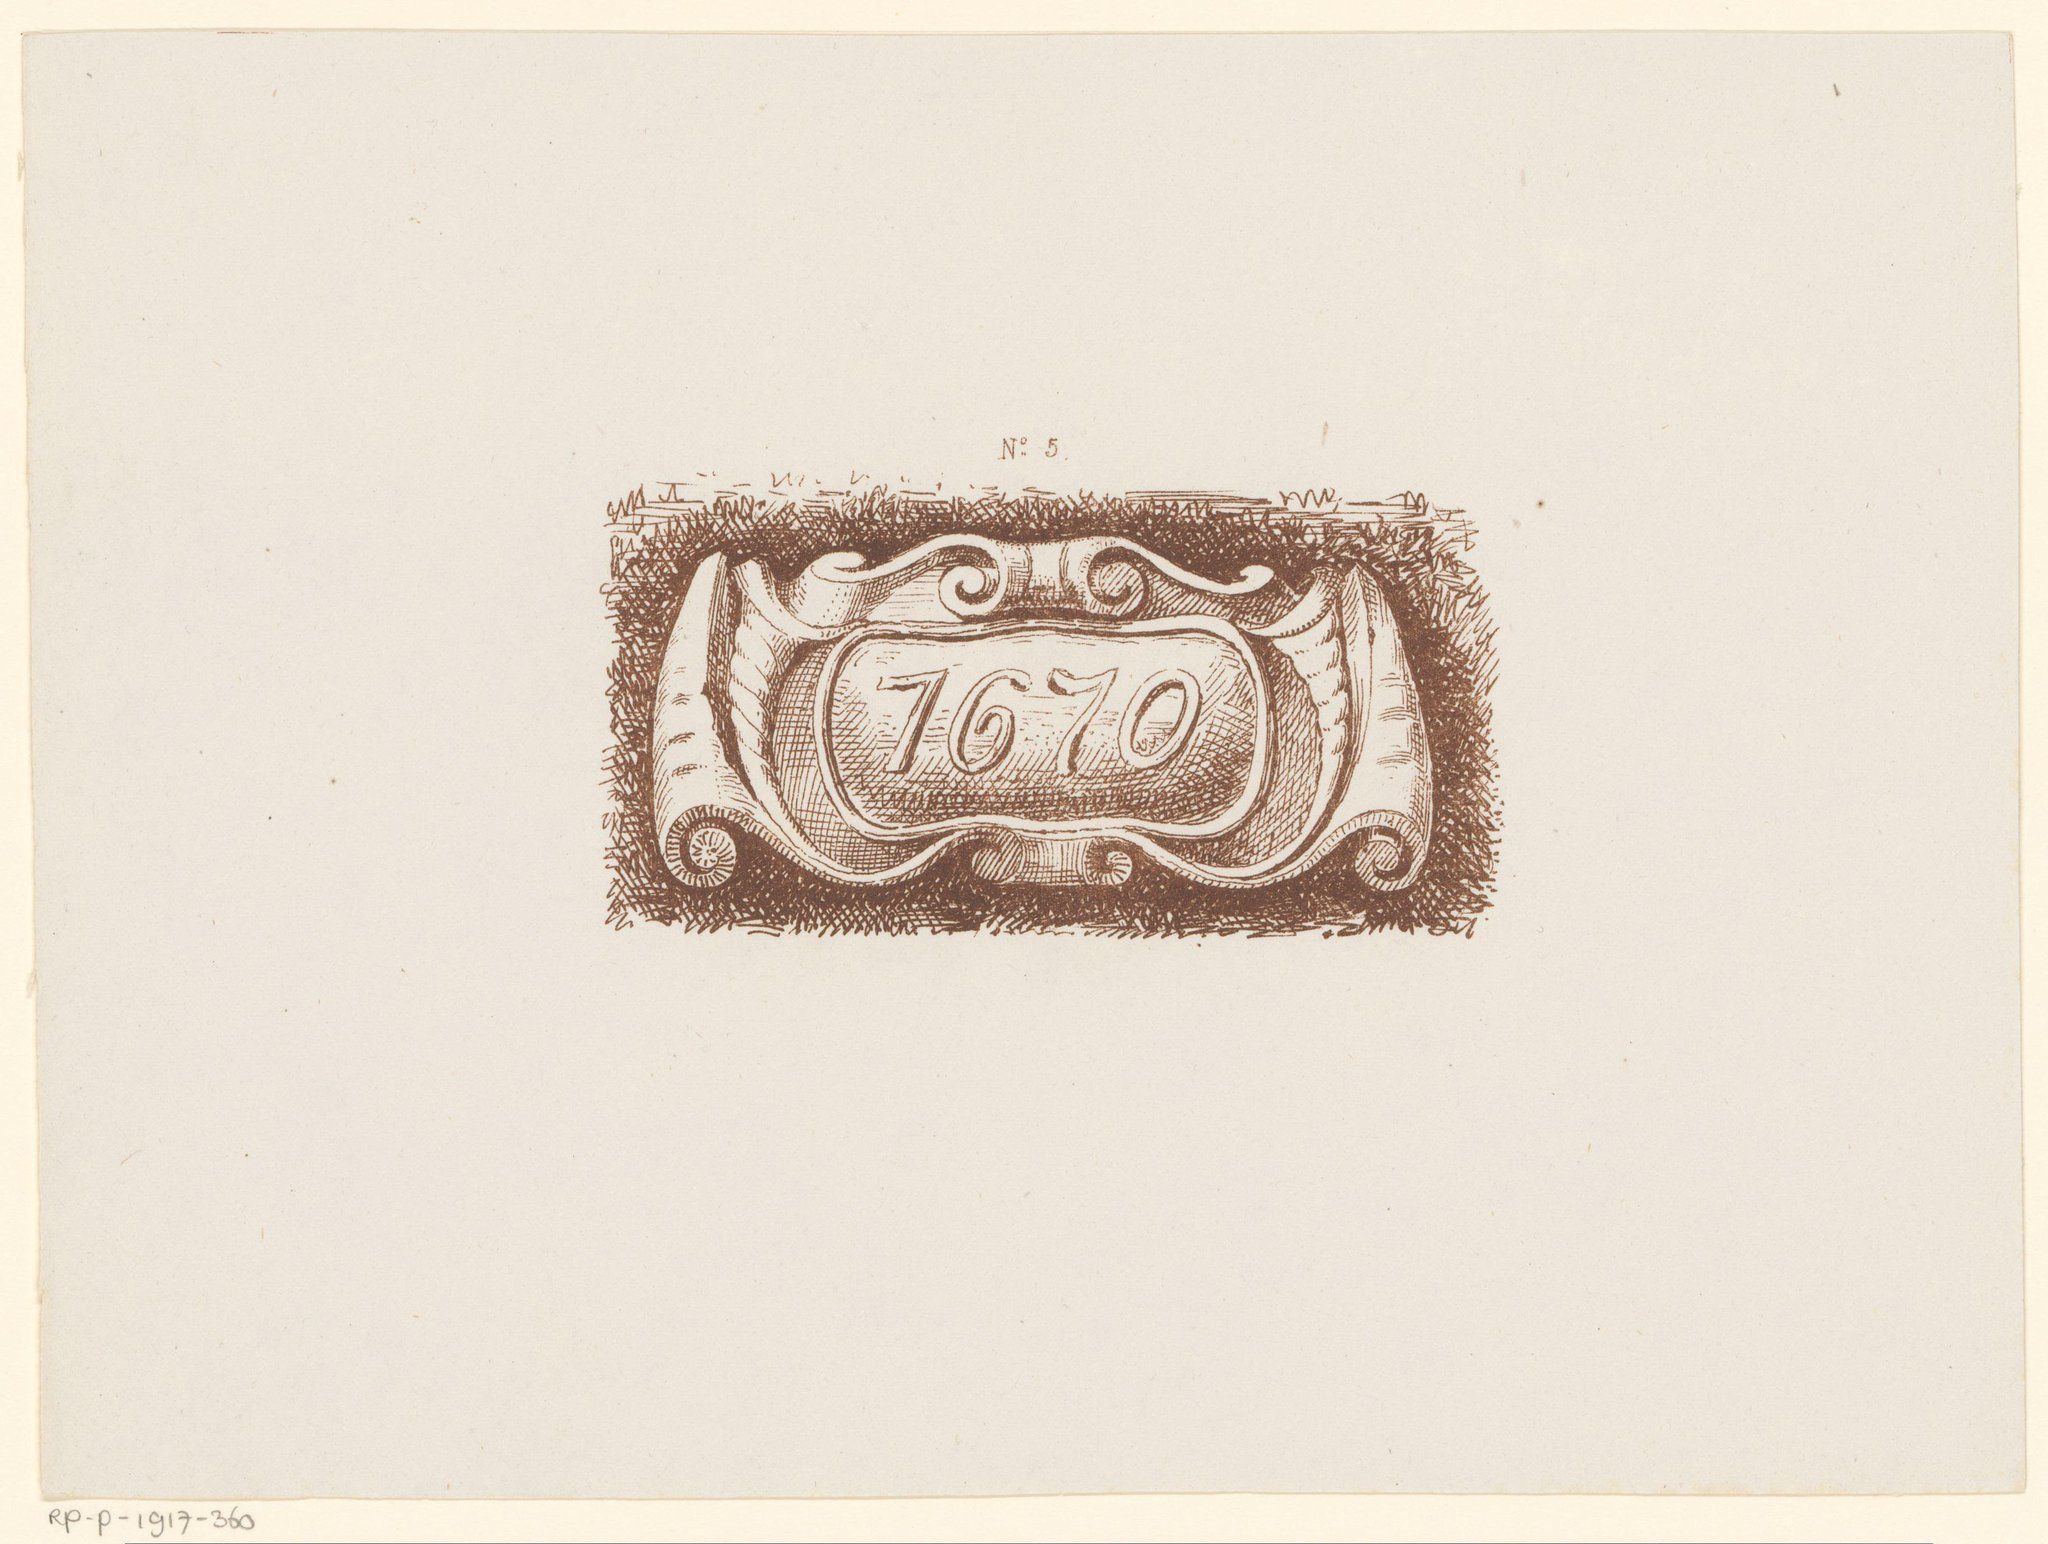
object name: print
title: Cartouche met het jaartal 1670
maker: jac van looij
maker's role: draughtsman, painter, print maker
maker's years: 1855-1930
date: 1877-1894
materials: paper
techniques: lithograph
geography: amsterdam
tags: ornament ~ cartouche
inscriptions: collector's mark: Lugt 2228